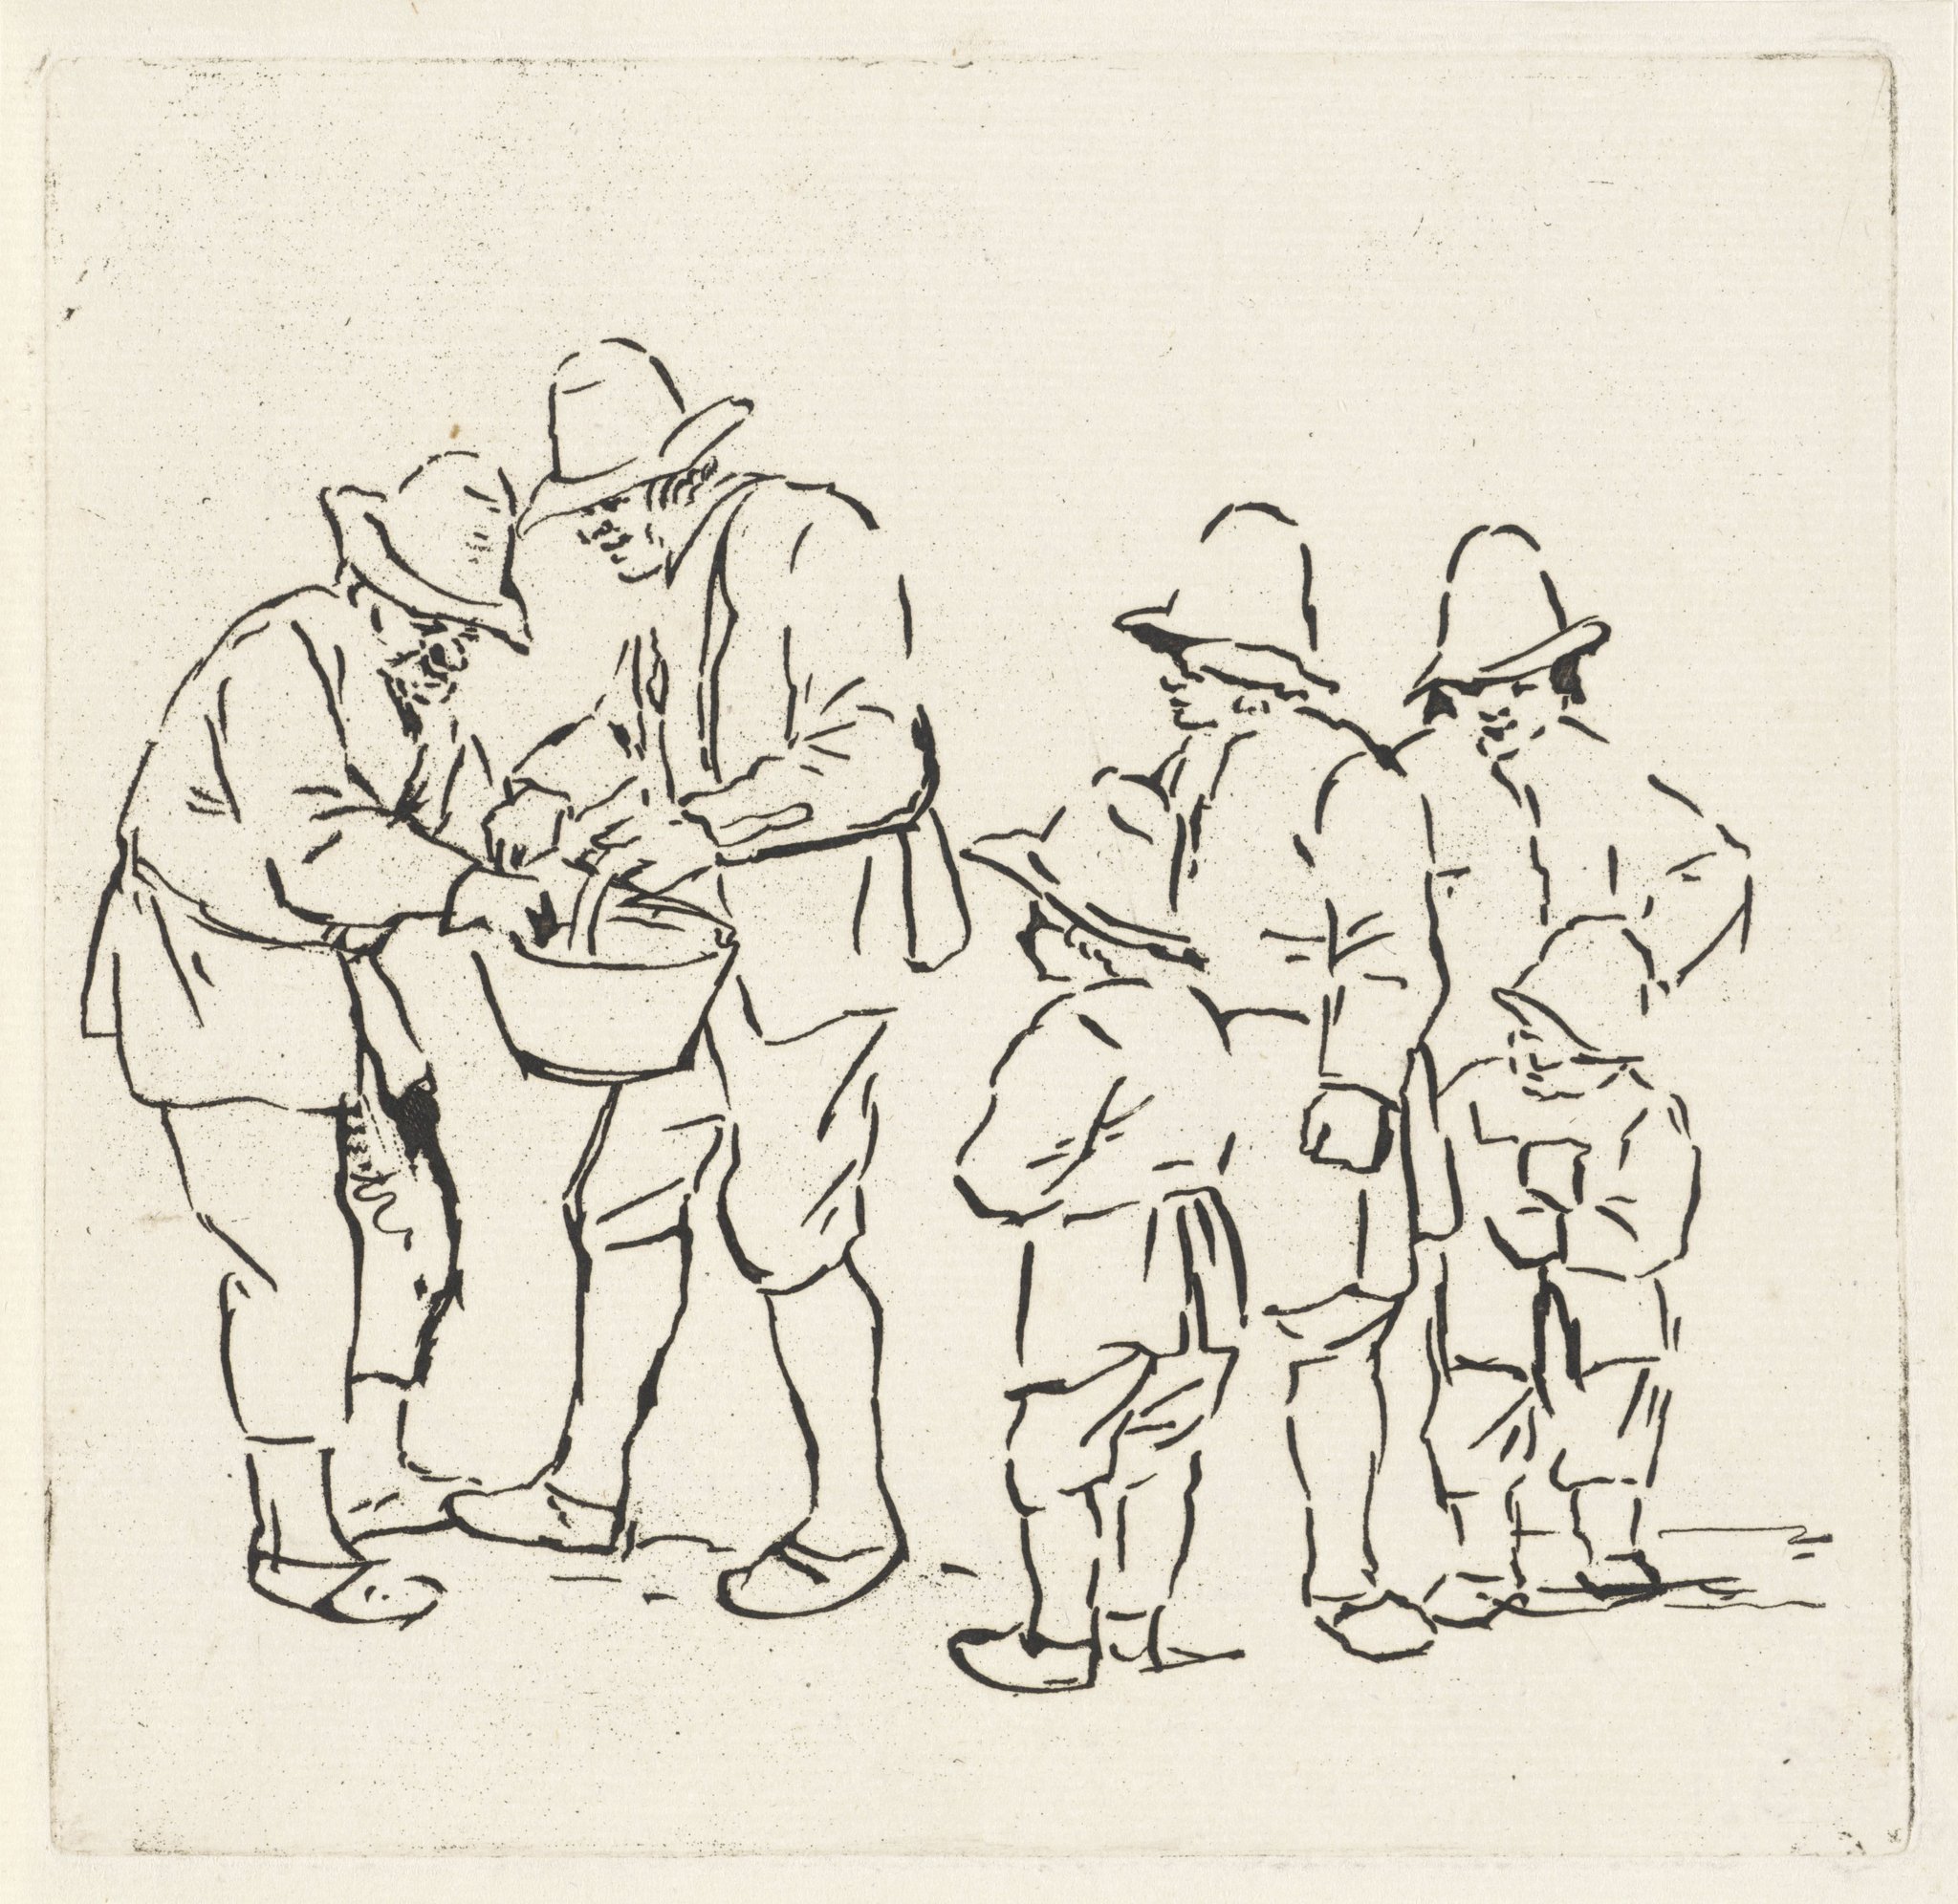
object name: print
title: Groep mannen en jongens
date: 1772-1828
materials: paper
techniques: etching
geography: leiden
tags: container made of plant material other than wood: basket, father and child(ren), man and child(ren) (family group)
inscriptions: collector's mark: Lugt 240, dedication: ‘Onafgemaakte druk na een tekeningetje van juffrouw Cristina Chalon geoffereert door de heer van Vlaardingen door de hr. Van Buren’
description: Twee mannen houden een mand vast en drie jongens kijken toe.